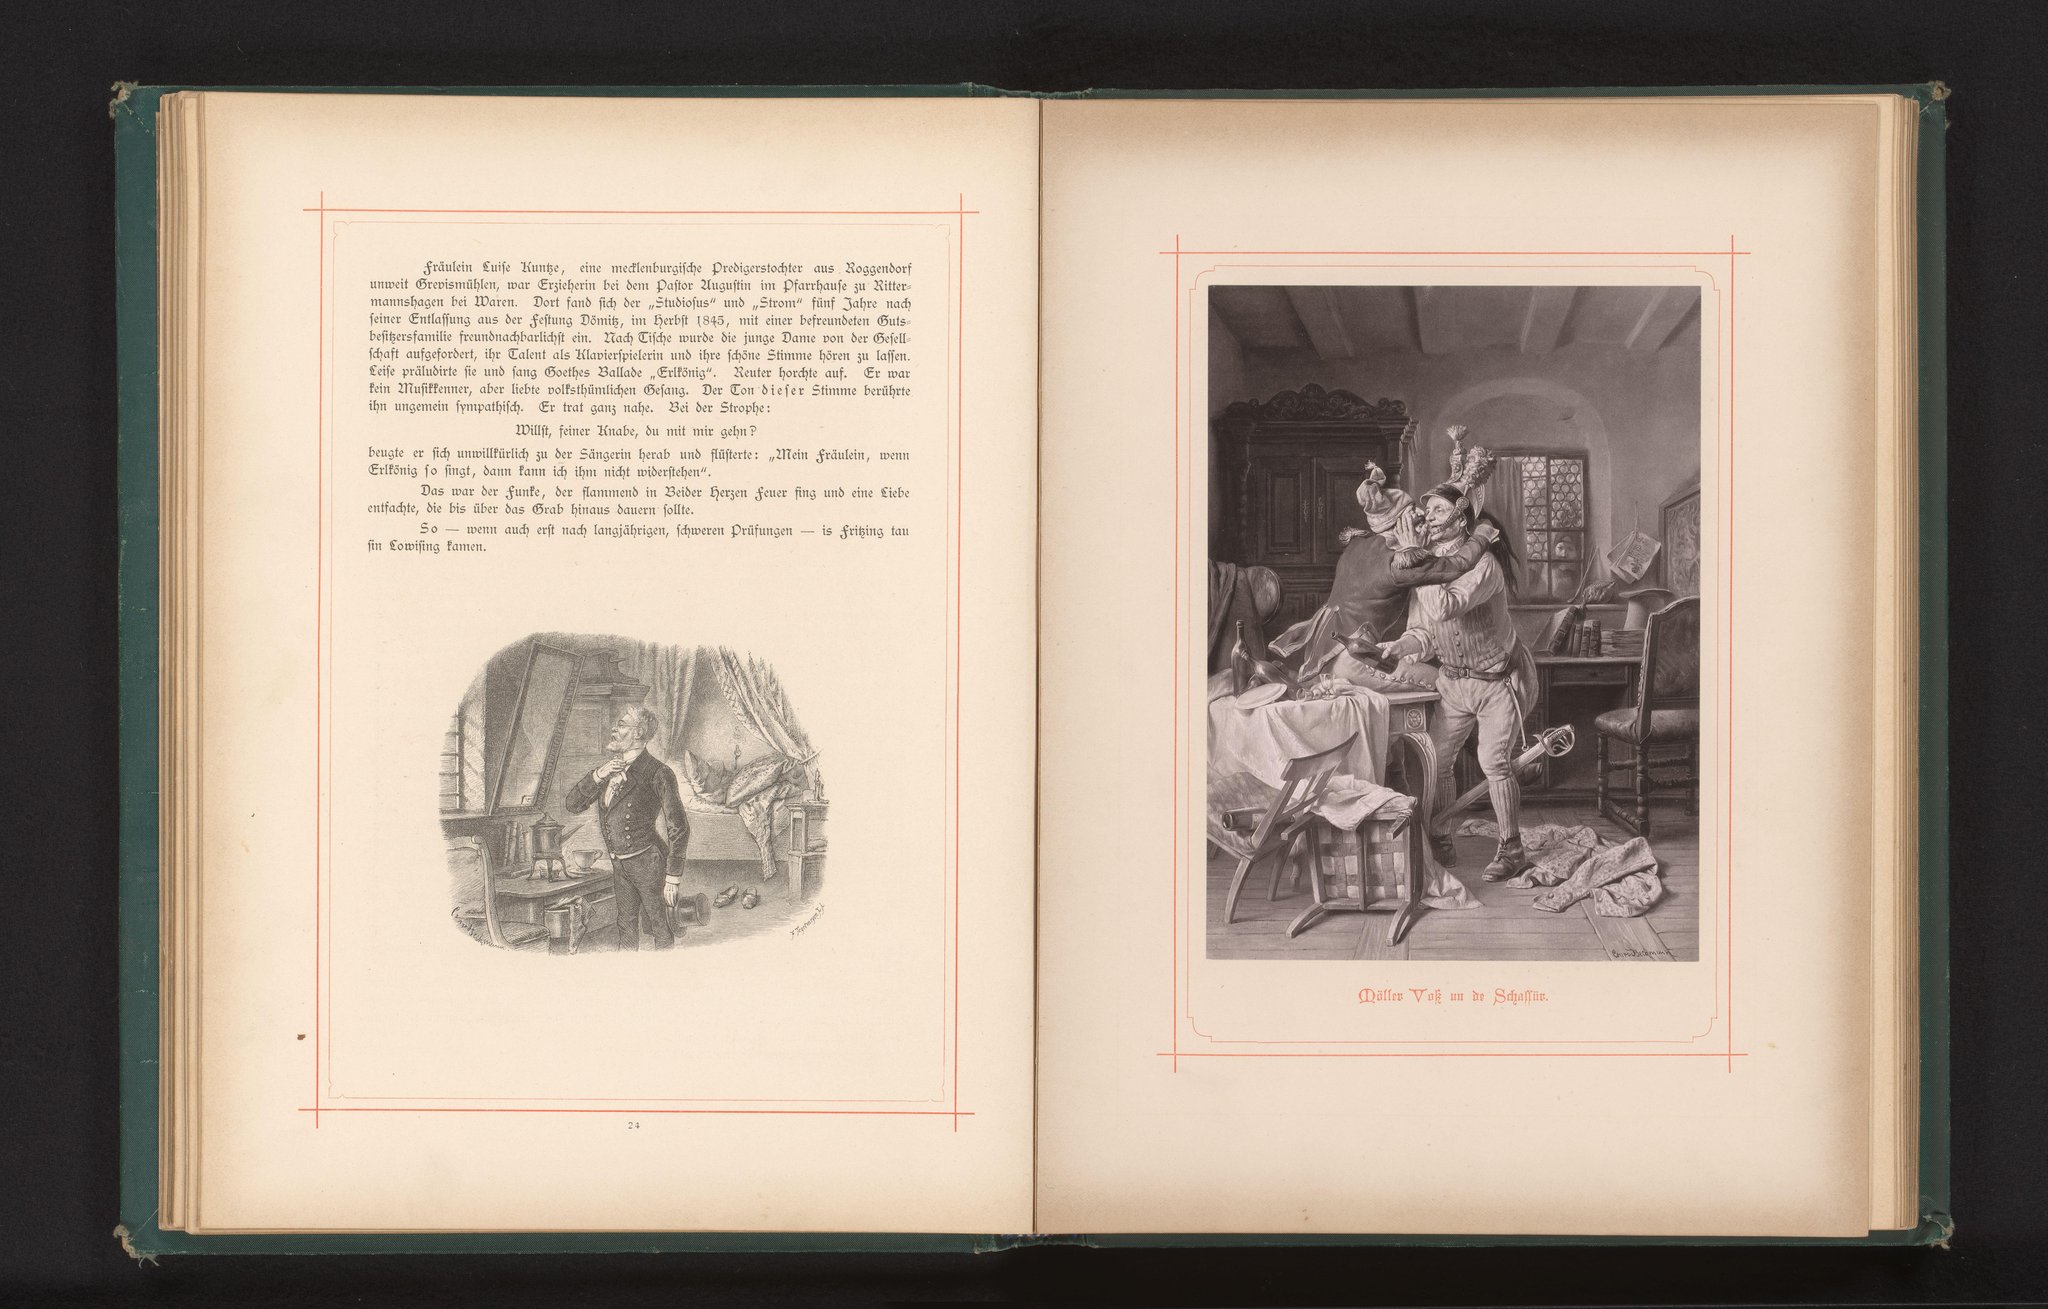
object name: photomechanical print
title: Möller Voß un de Schaffür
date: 1874-1884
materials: paper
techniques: photograph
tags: picture, painting, drinking